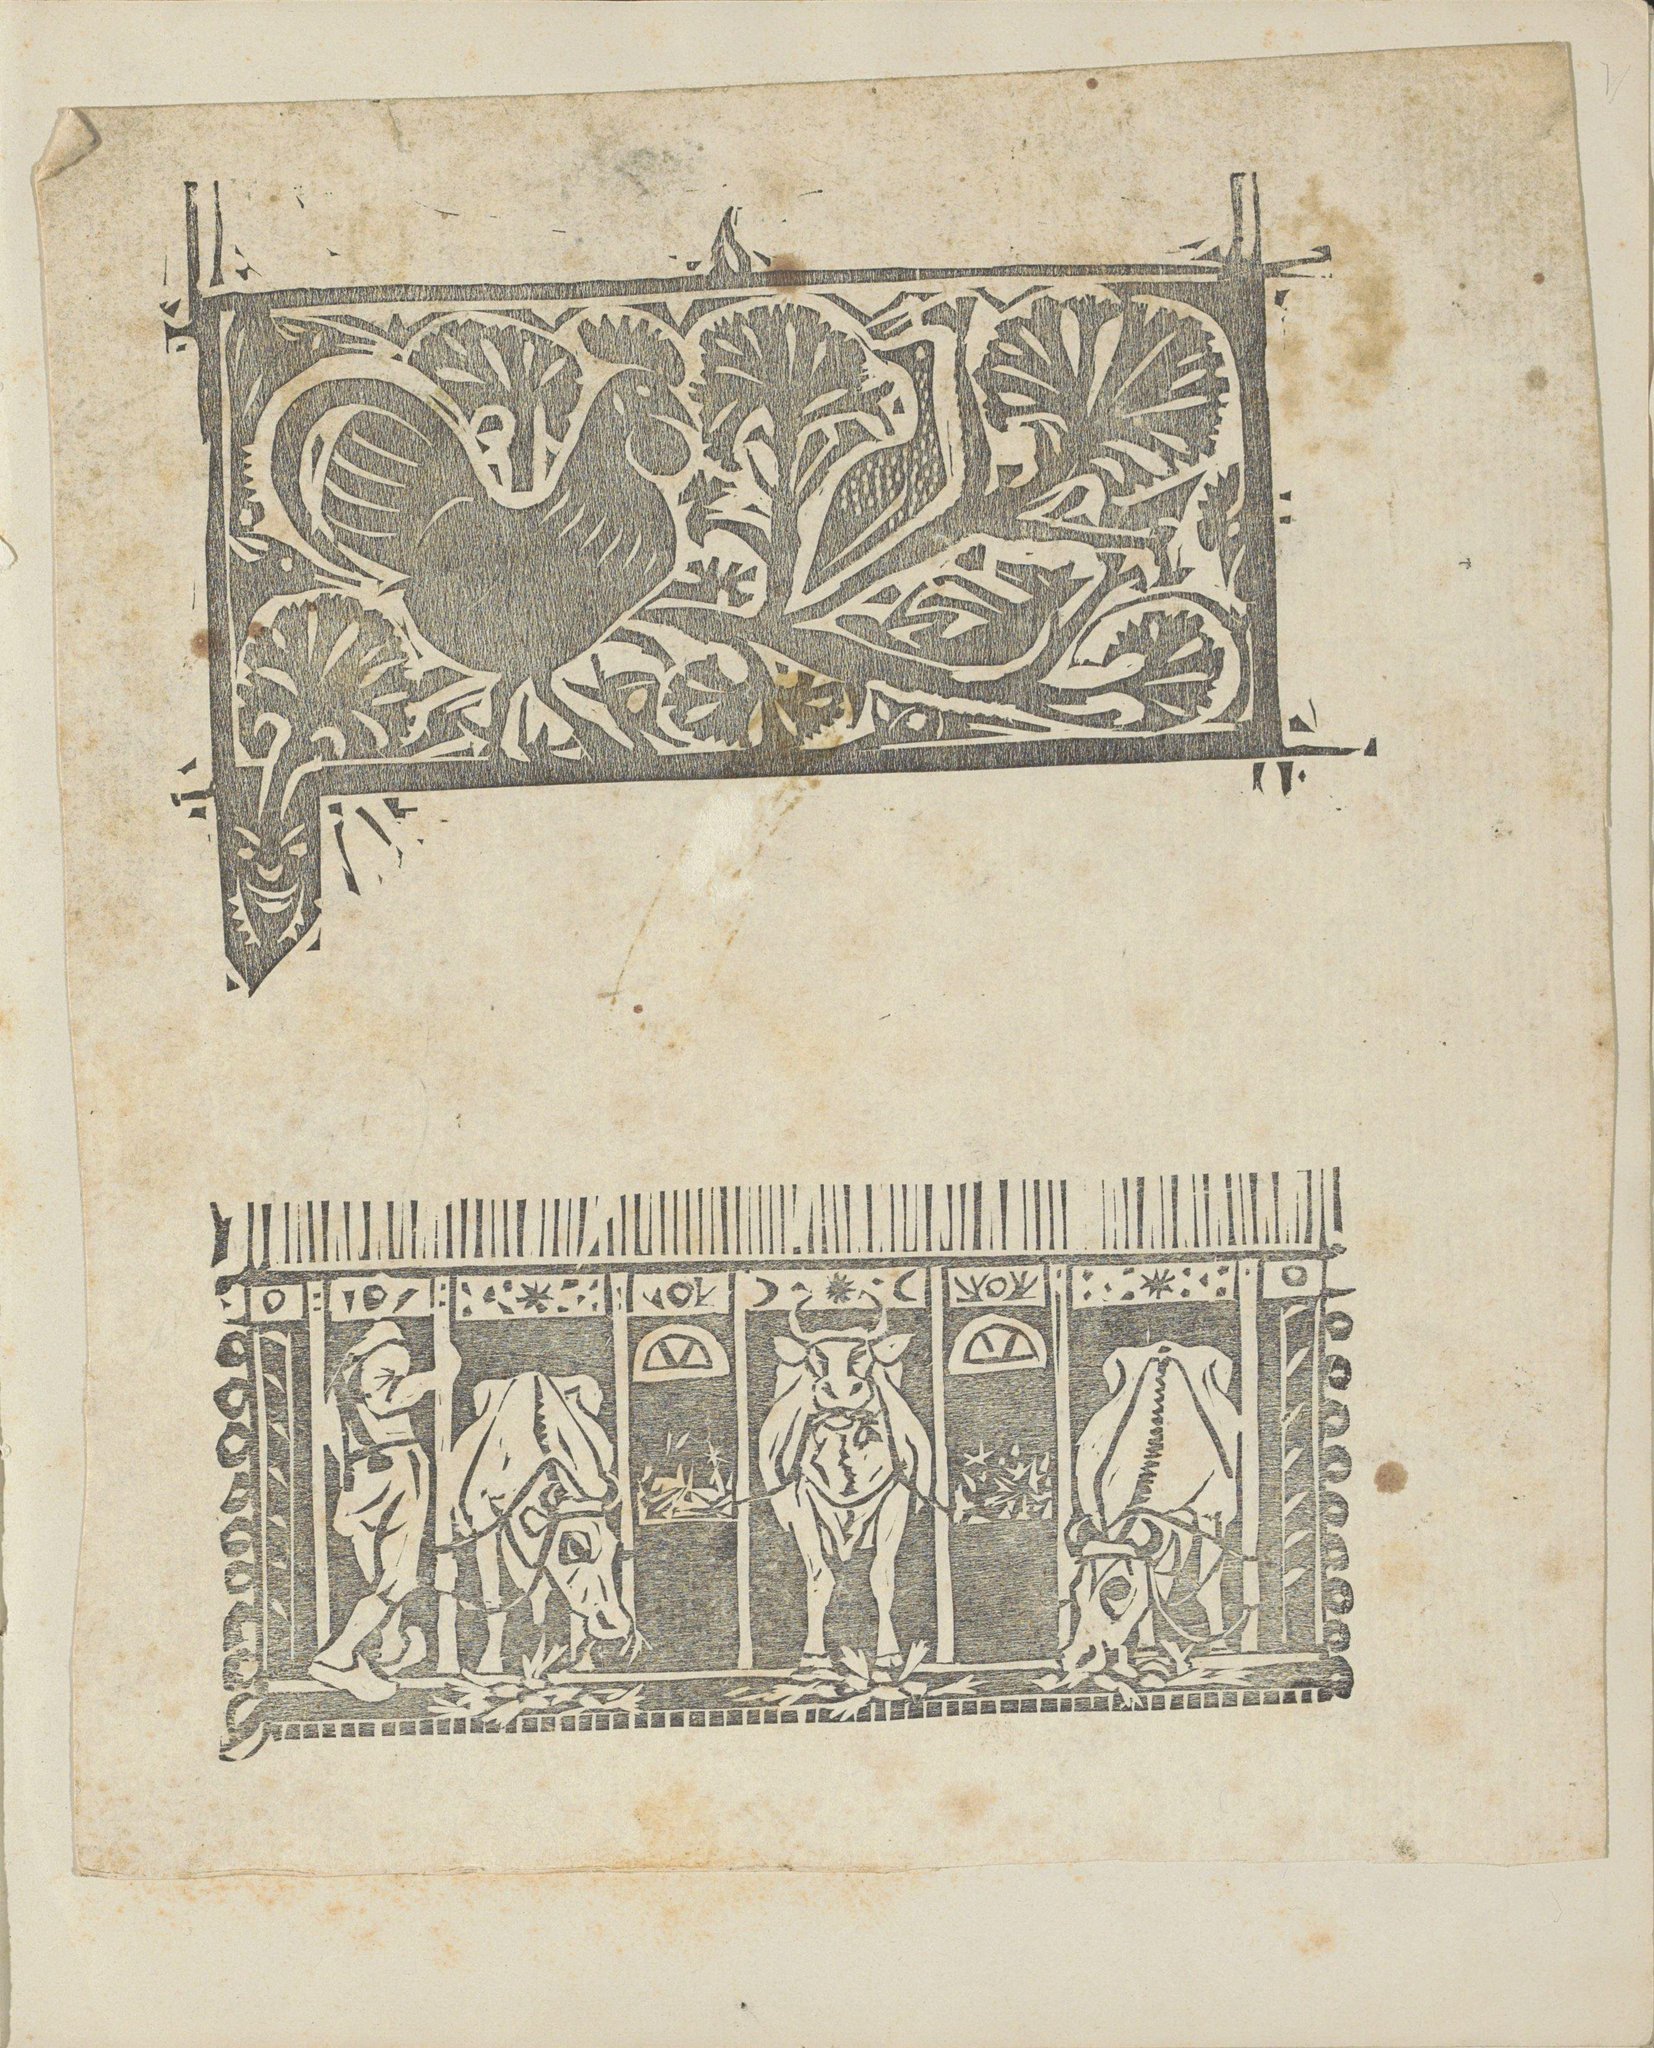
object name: album leaf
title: Twee ornamenten met dieren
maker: gerrit willem dijsselhof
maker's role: designer, draughtsman, print maker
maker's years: 1866-1924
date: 1876-1924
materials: paper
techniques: woodcut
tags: cow, ornament derived from animal forms, fowl (cock, hen, chicken, etc.)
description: Ornament met een haan en vogel tegen een achtergrond van bomen en een ornament met drie runderen tegen een decoratieve achtergrond. Blad 10 recto uit een album met 17 bladen.